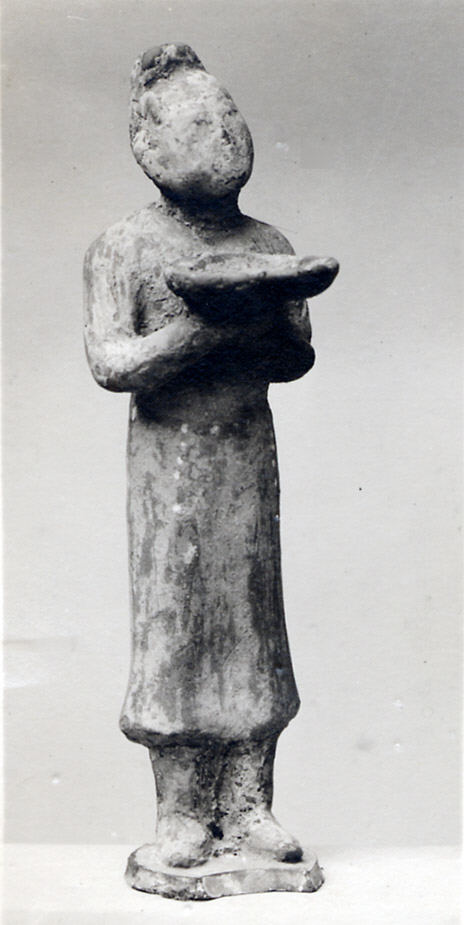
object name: figure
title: Male attendant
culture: chinese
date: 601-800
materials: earthenware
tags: human figures